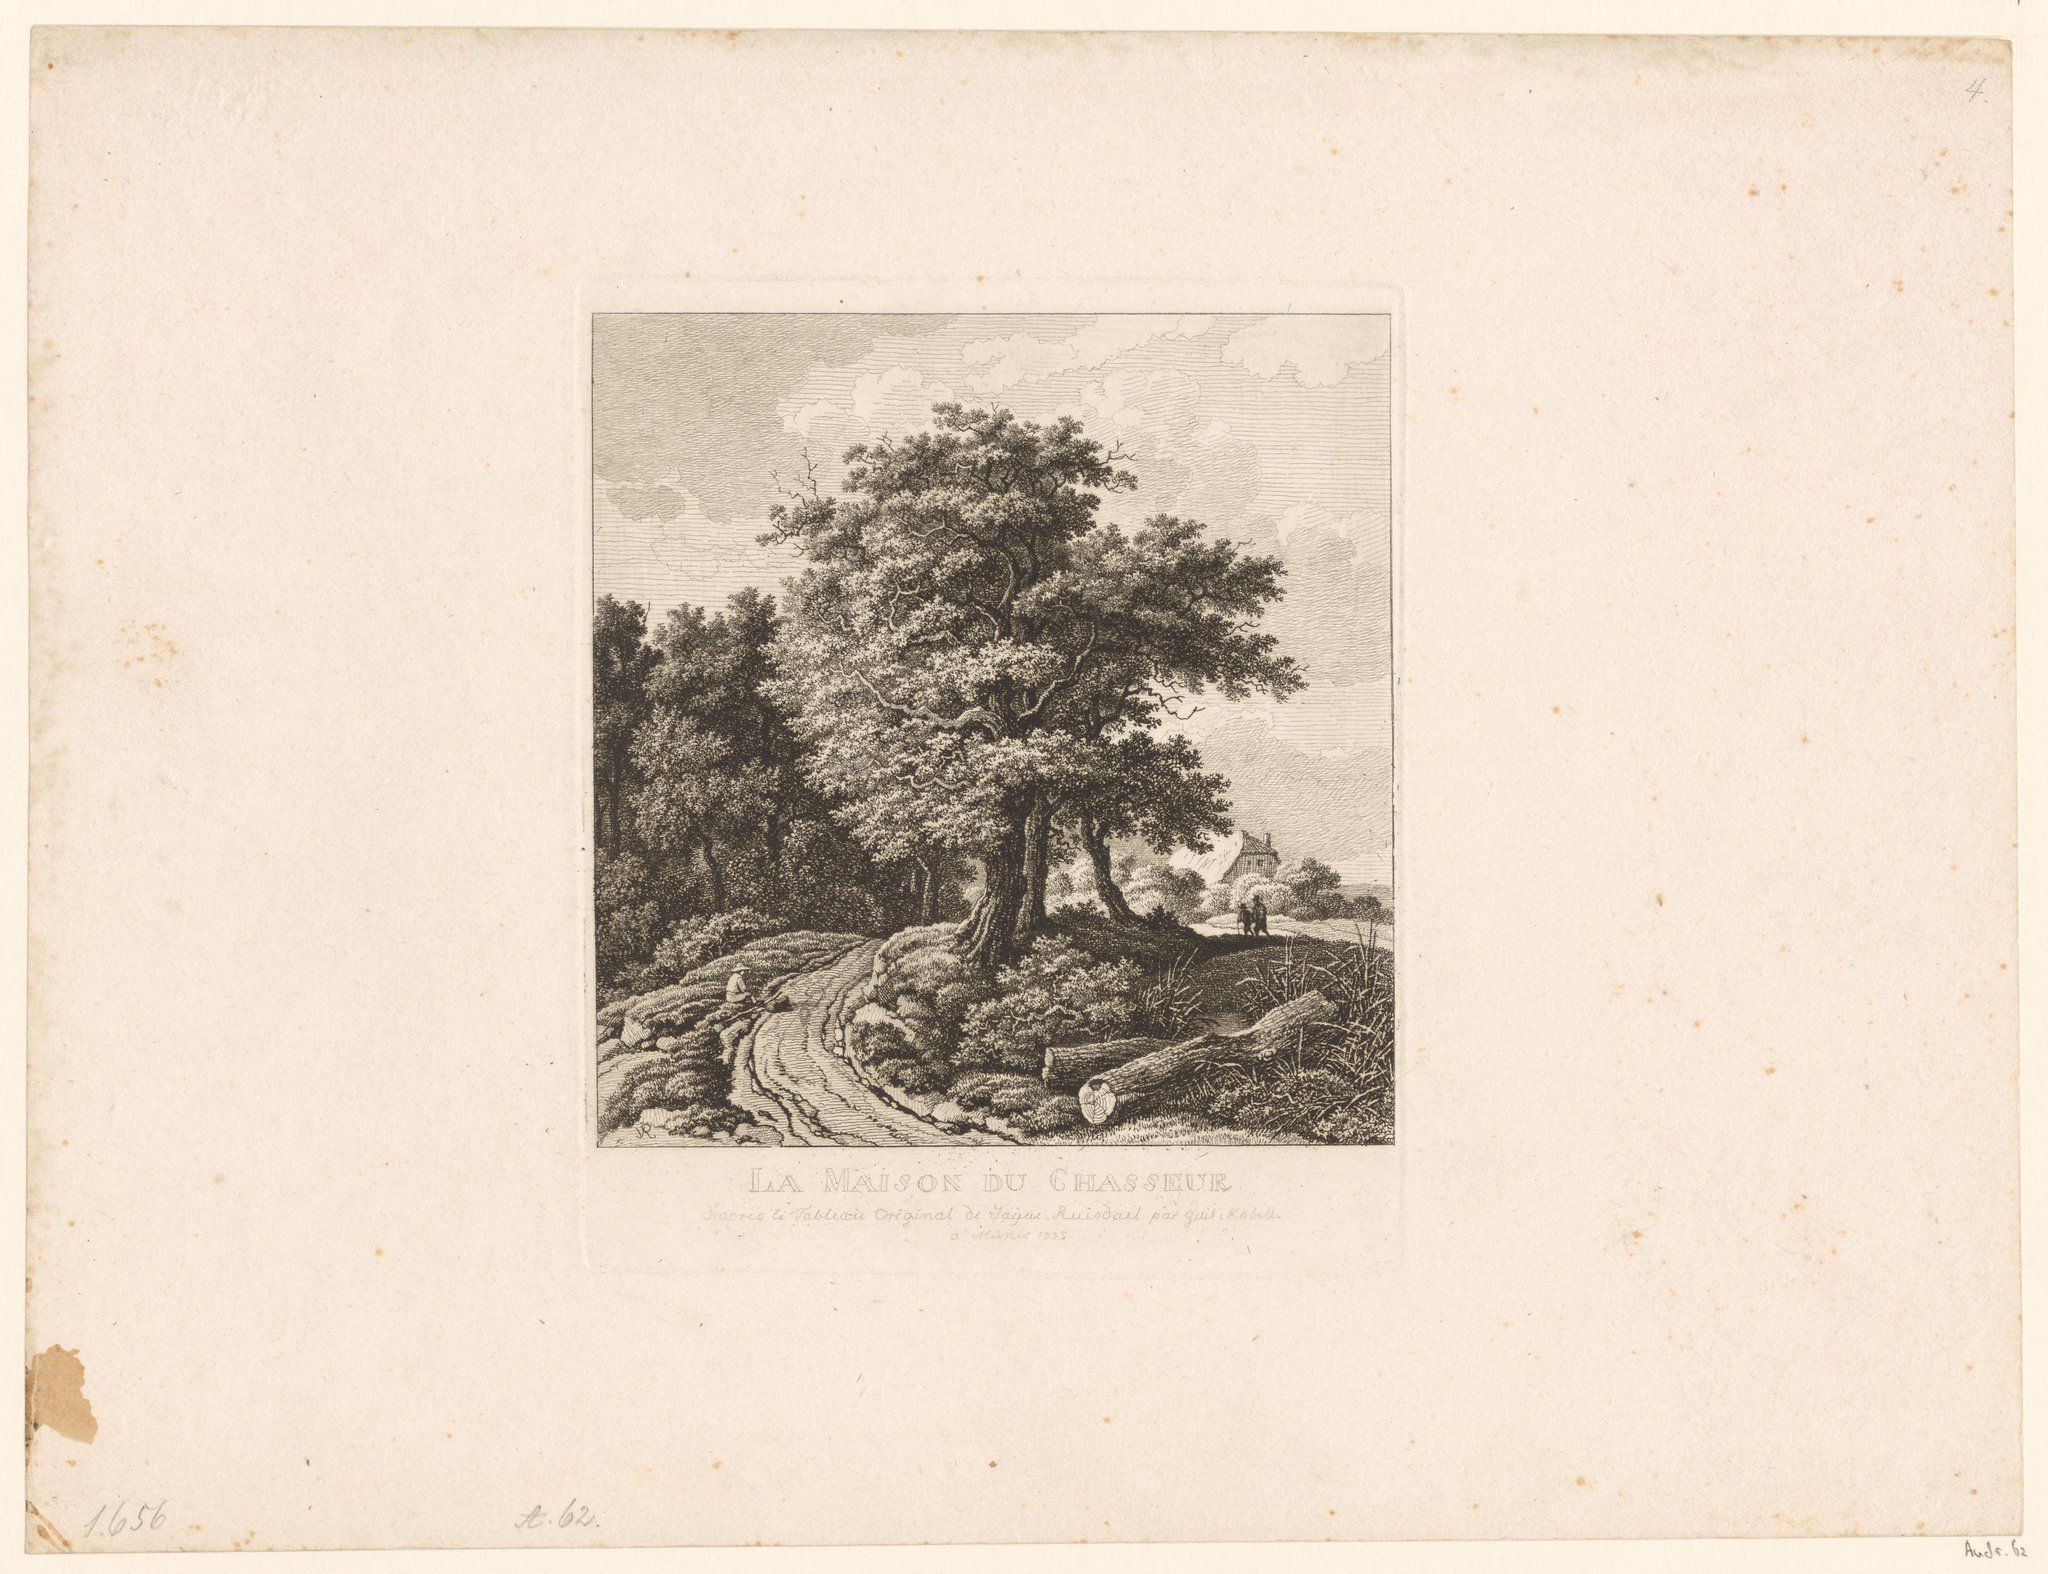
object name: print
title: La Maison du Chasseur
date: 1835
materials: paper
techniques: etching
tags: rural housing, e.g. country-house, villa, cottage, forest path or lane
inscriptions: collector's mark: Lugt 2228